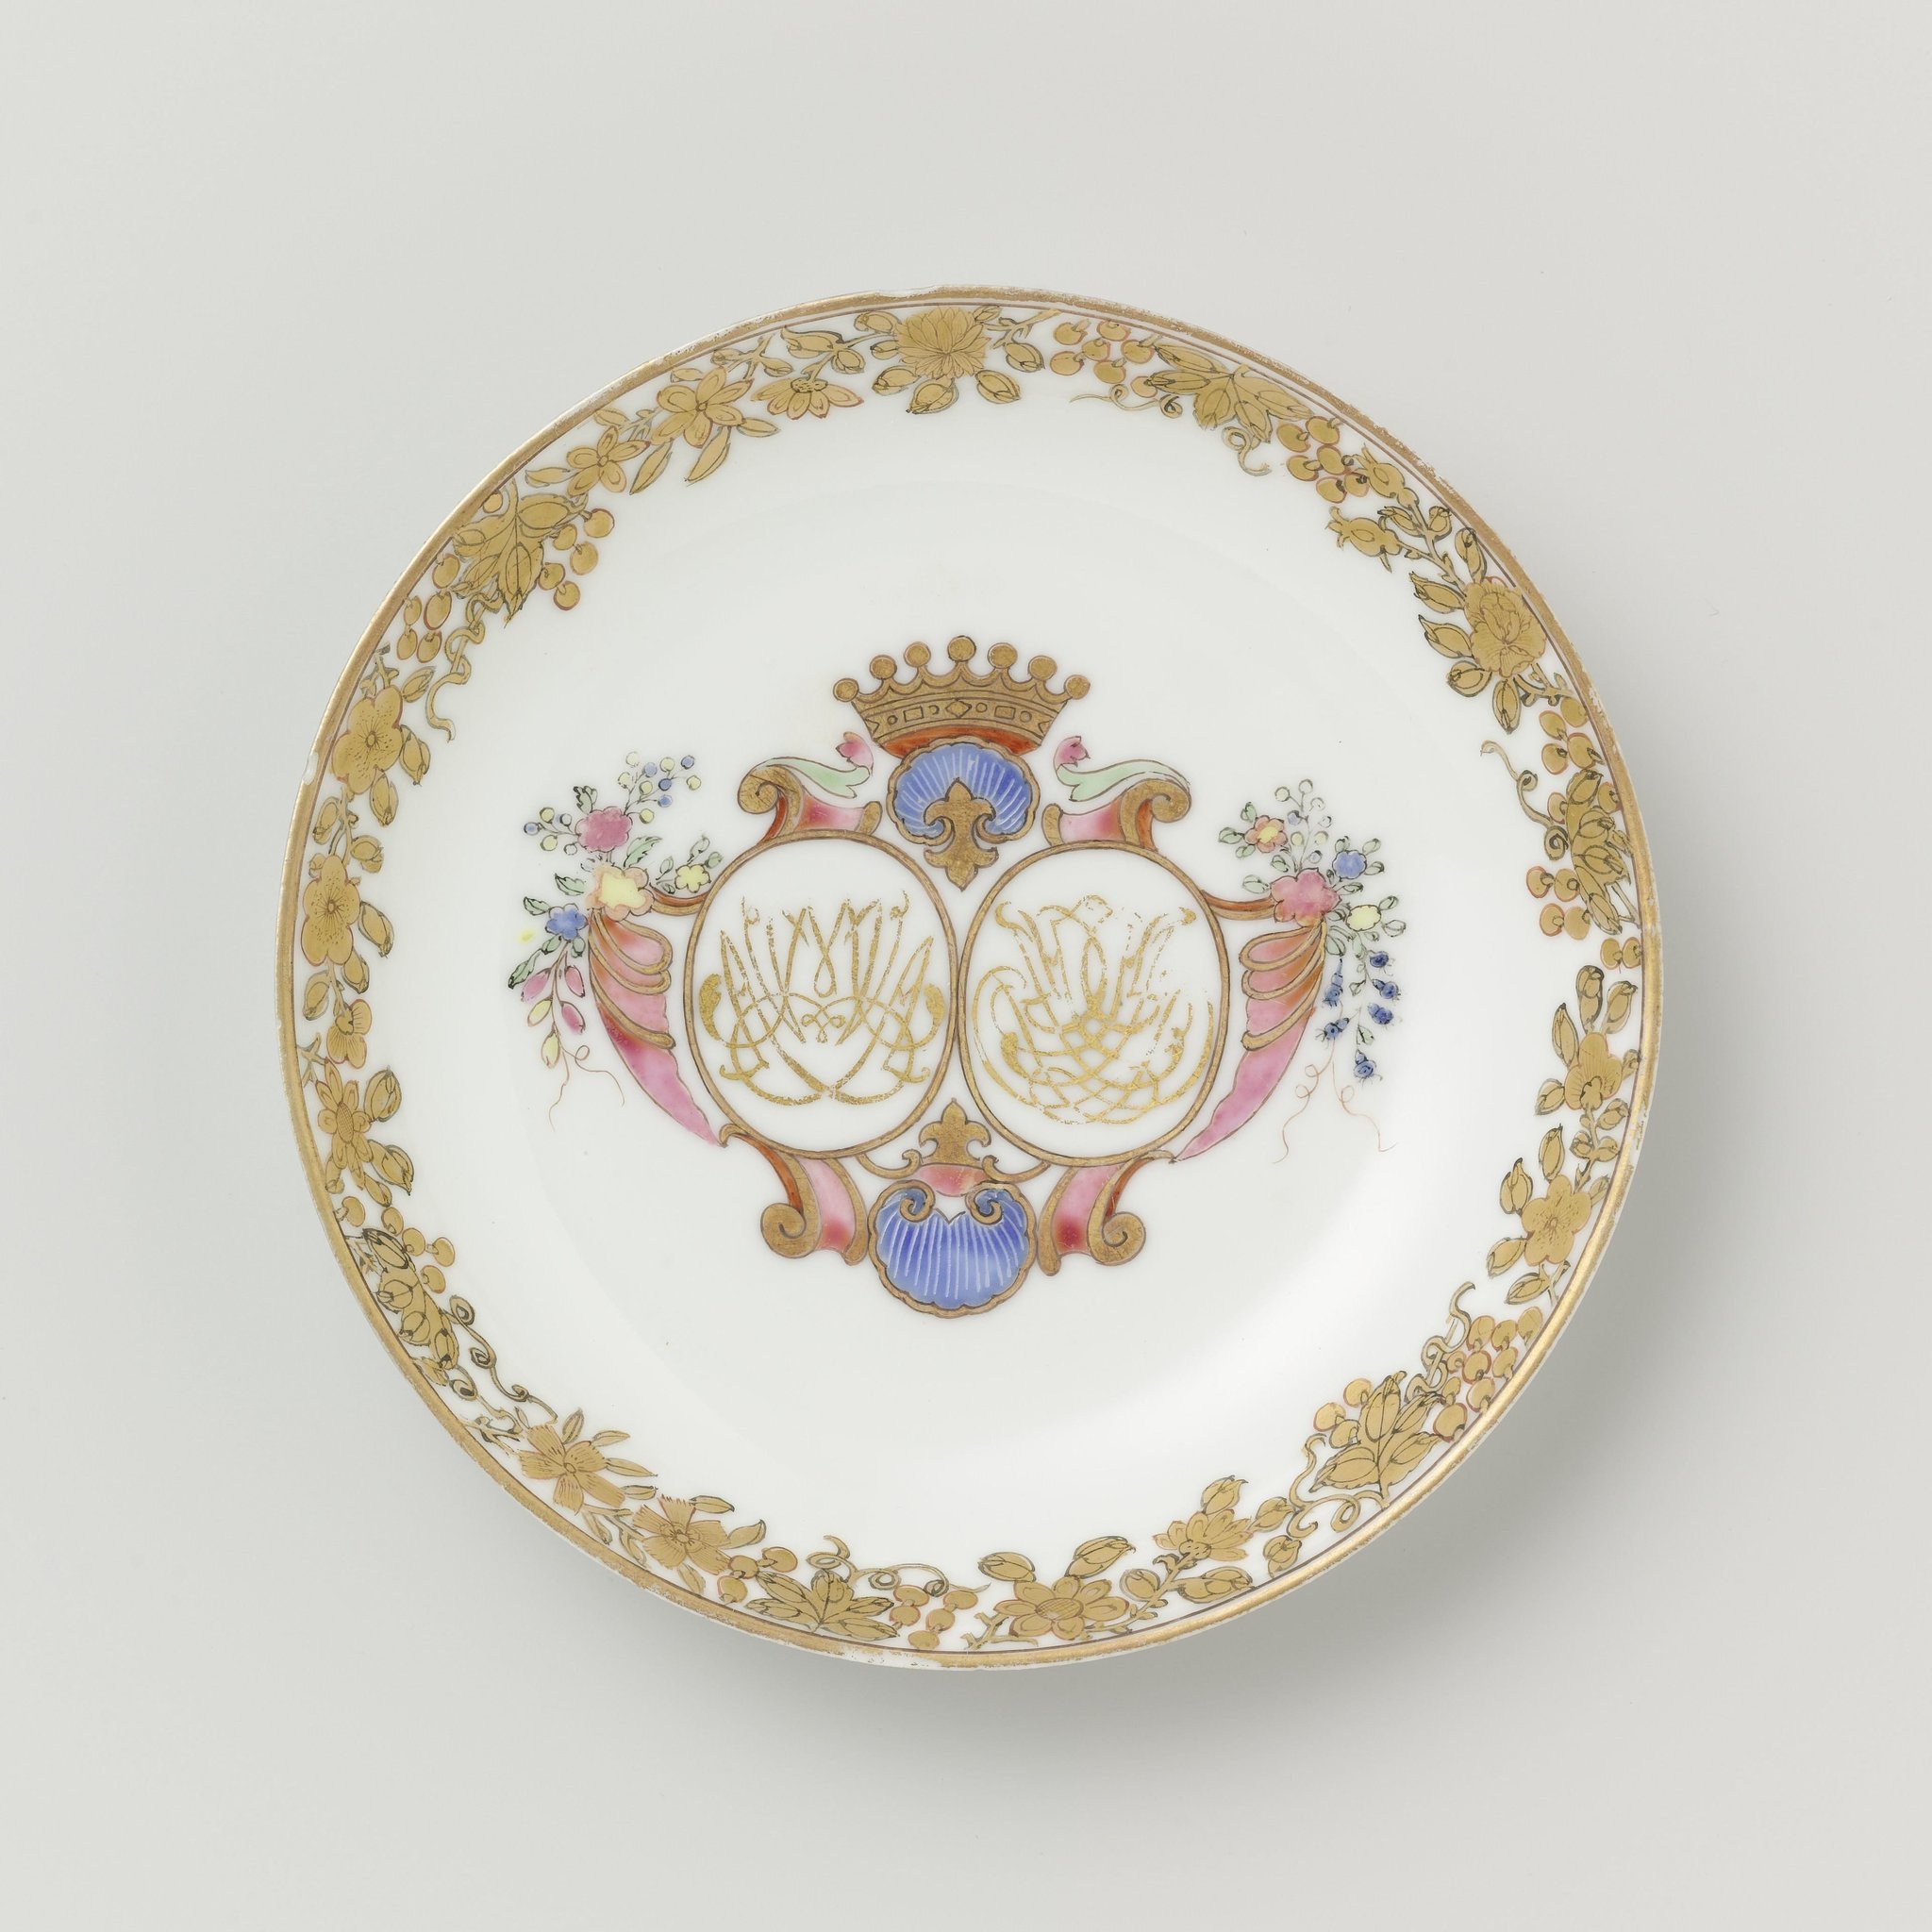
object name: platter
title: Saucer from the 'Swellengrebel service' with a double crowned monogram and a border with floral scrolls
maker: Anonymous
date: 1740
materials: glaze, gold, paint, porcelain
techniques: firing, gilding, turning, vitrification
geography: china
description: De monogrammen 'MVA' en 'CHTD' staan voor Maurits van Aerden (1694-1746) en Constantia Helena ten Damme (1694-1772), getrouwd in 1716. Het servies is waarschijnlijk besteld ter ere van hun vijfentwingtigjarig huwelijksjubileum in 1741. (Campen, Jan van & Hartkamp-Jonxis, Ebeltje, Aziatische weelde : VOC-kunst in het Rijksmuseum, Zutphen 2011, p. 78)